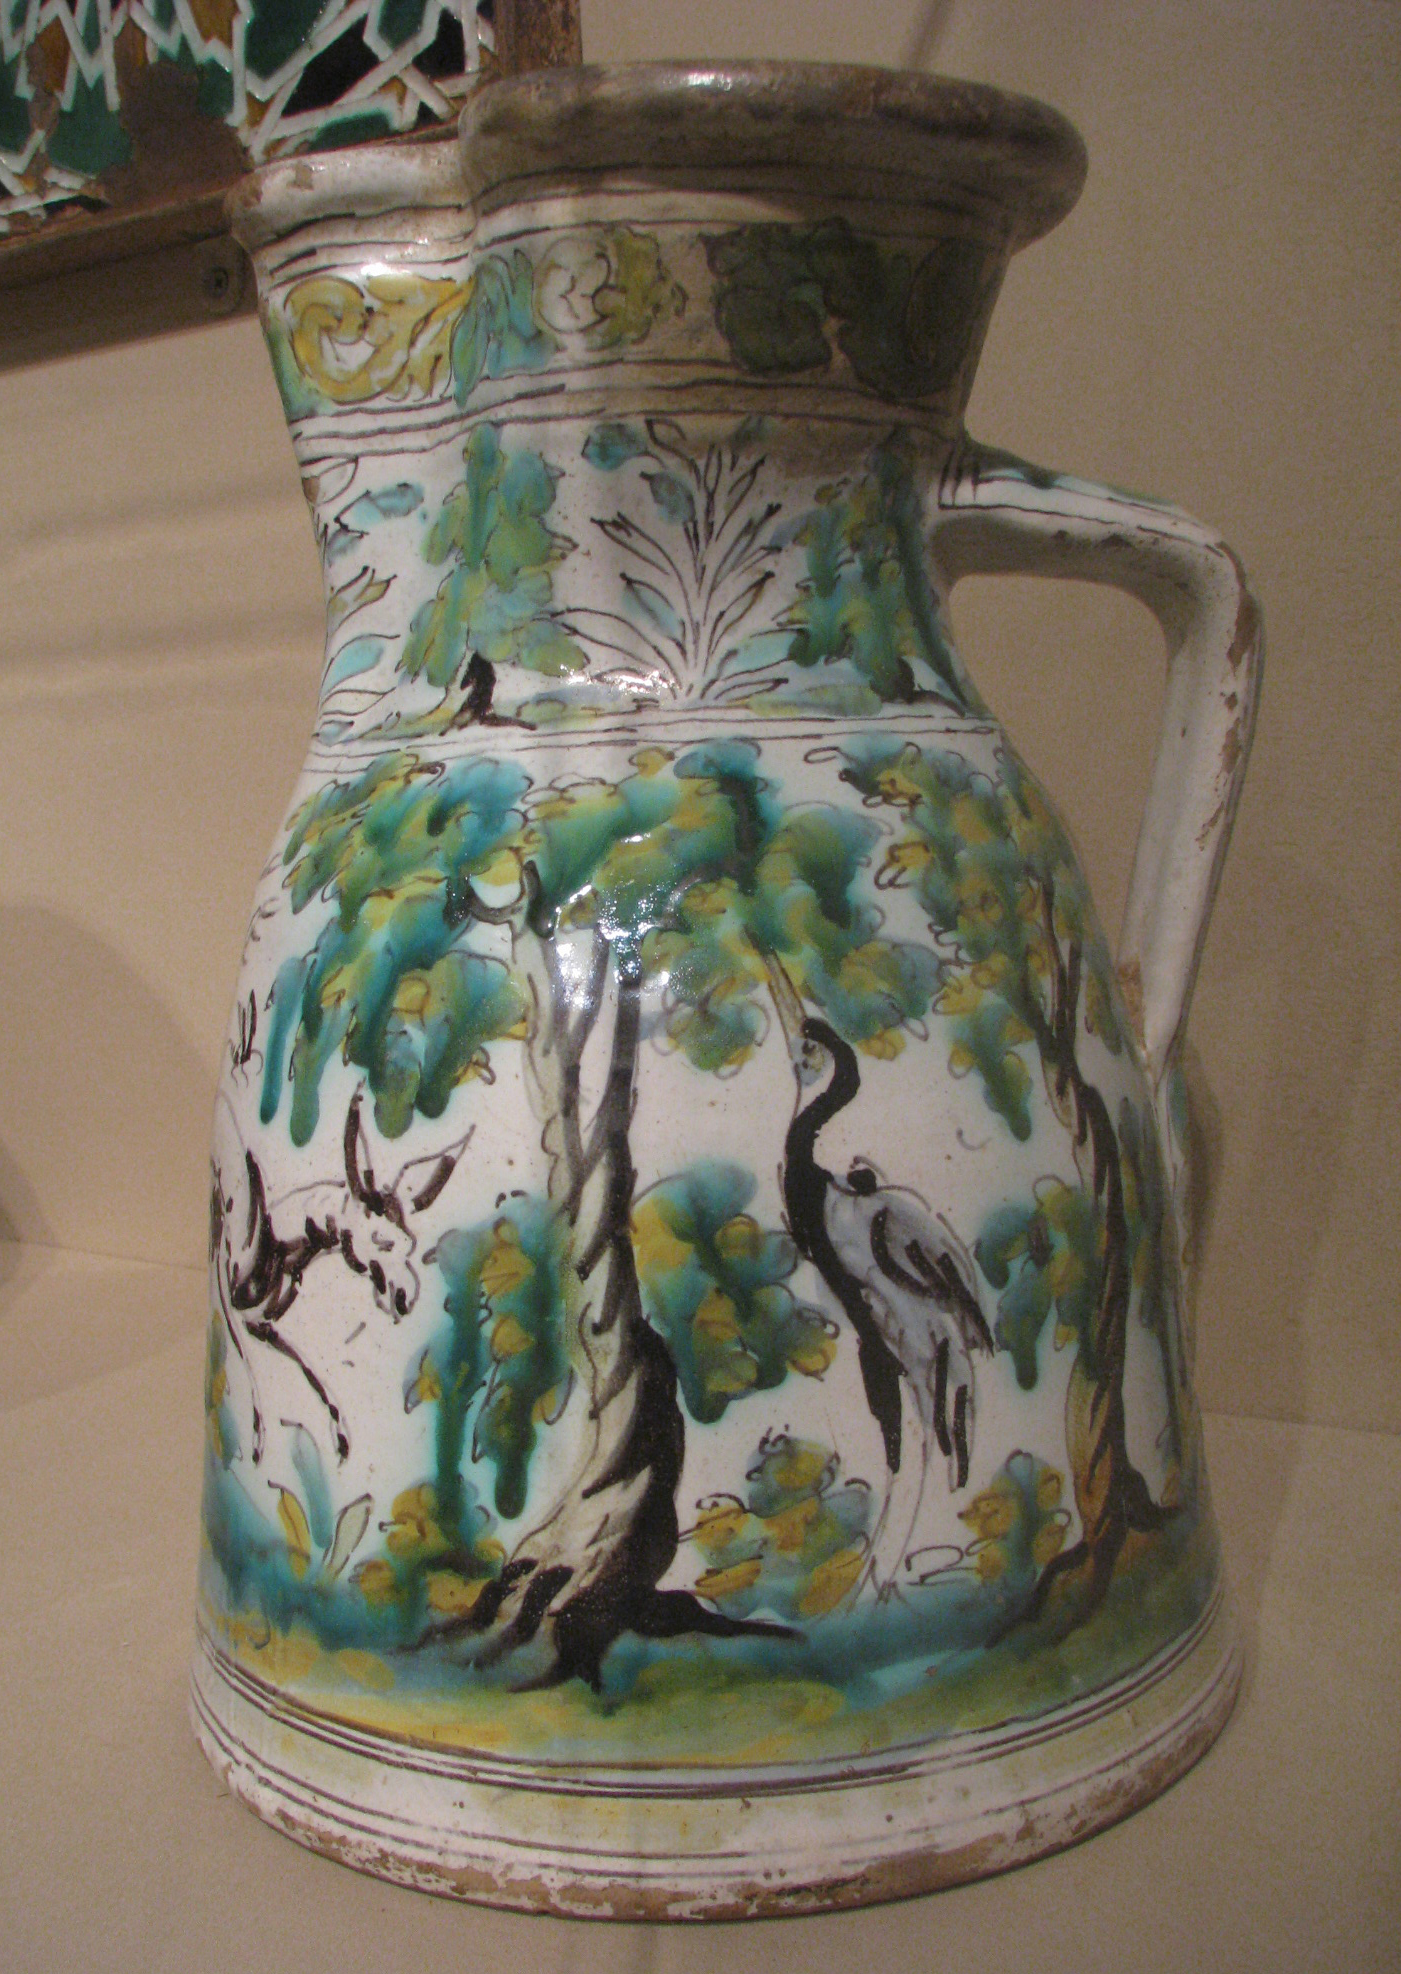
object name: jug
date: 1601-1700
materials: earthenware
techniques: glazing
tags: cranes,donkeys,trees